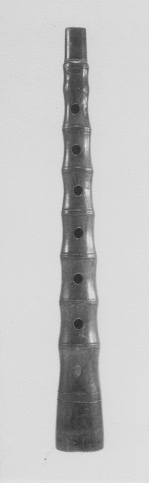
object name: suona body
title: Suona (嗩吶 ) body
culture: chinese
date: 1801-1900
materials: wood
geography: china